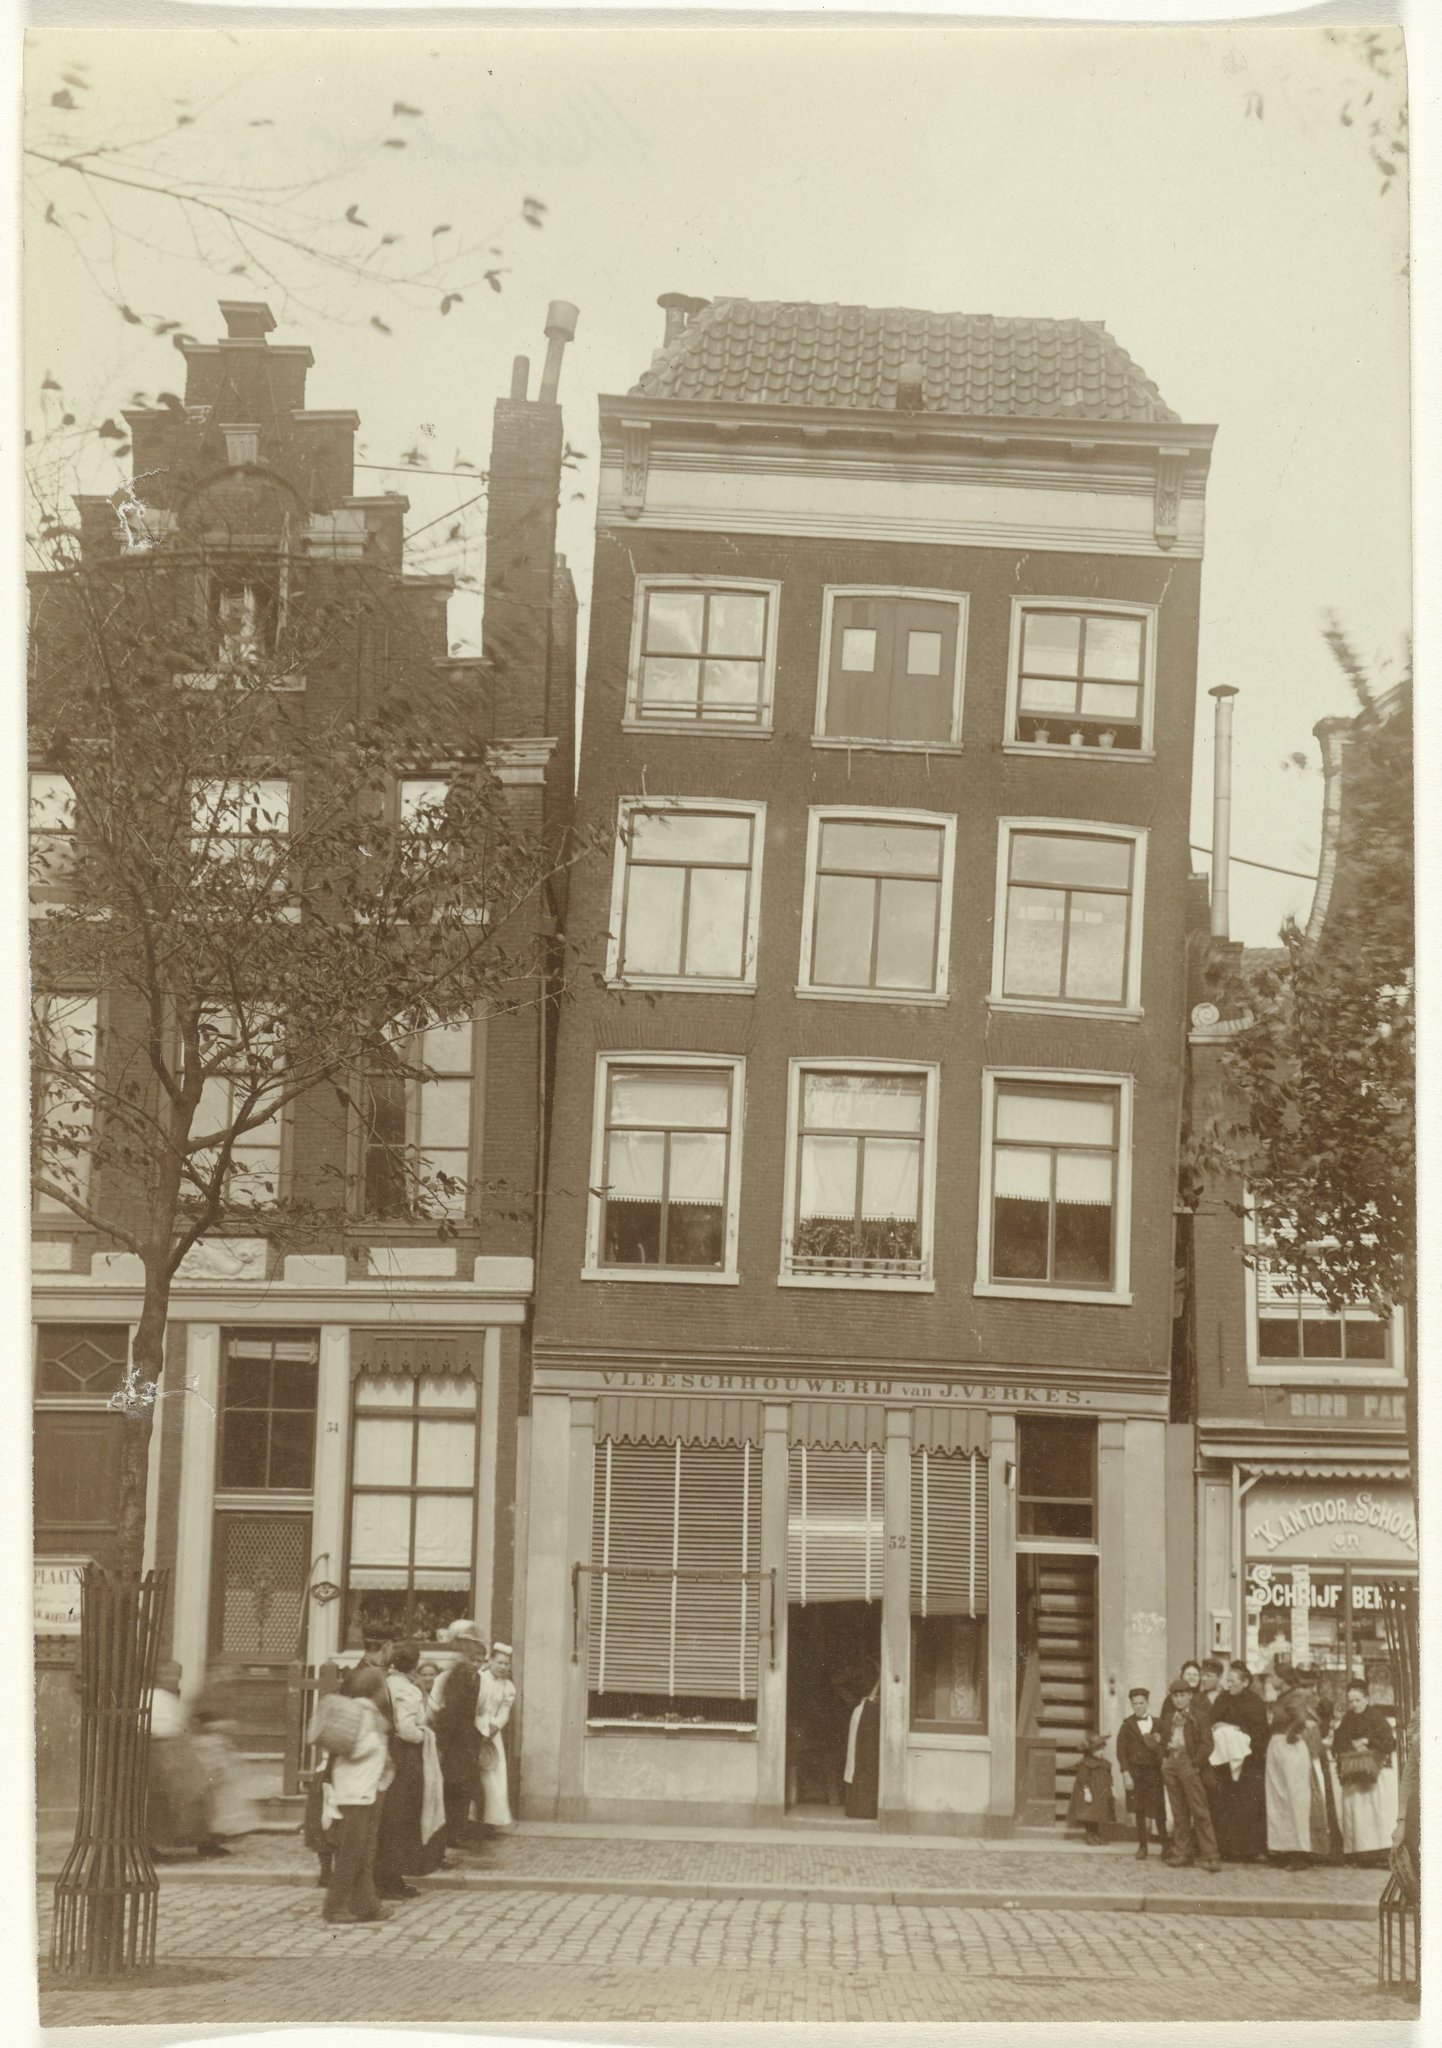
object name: photograph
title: Gezicht op Vleeschhouwerij J. Verkes aan Westerstraat 52 in Amsterdam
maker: Anonymous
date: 1886-1910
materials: paper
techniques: matte daylight collodion silver print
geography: amsterdam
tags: house combined with shop